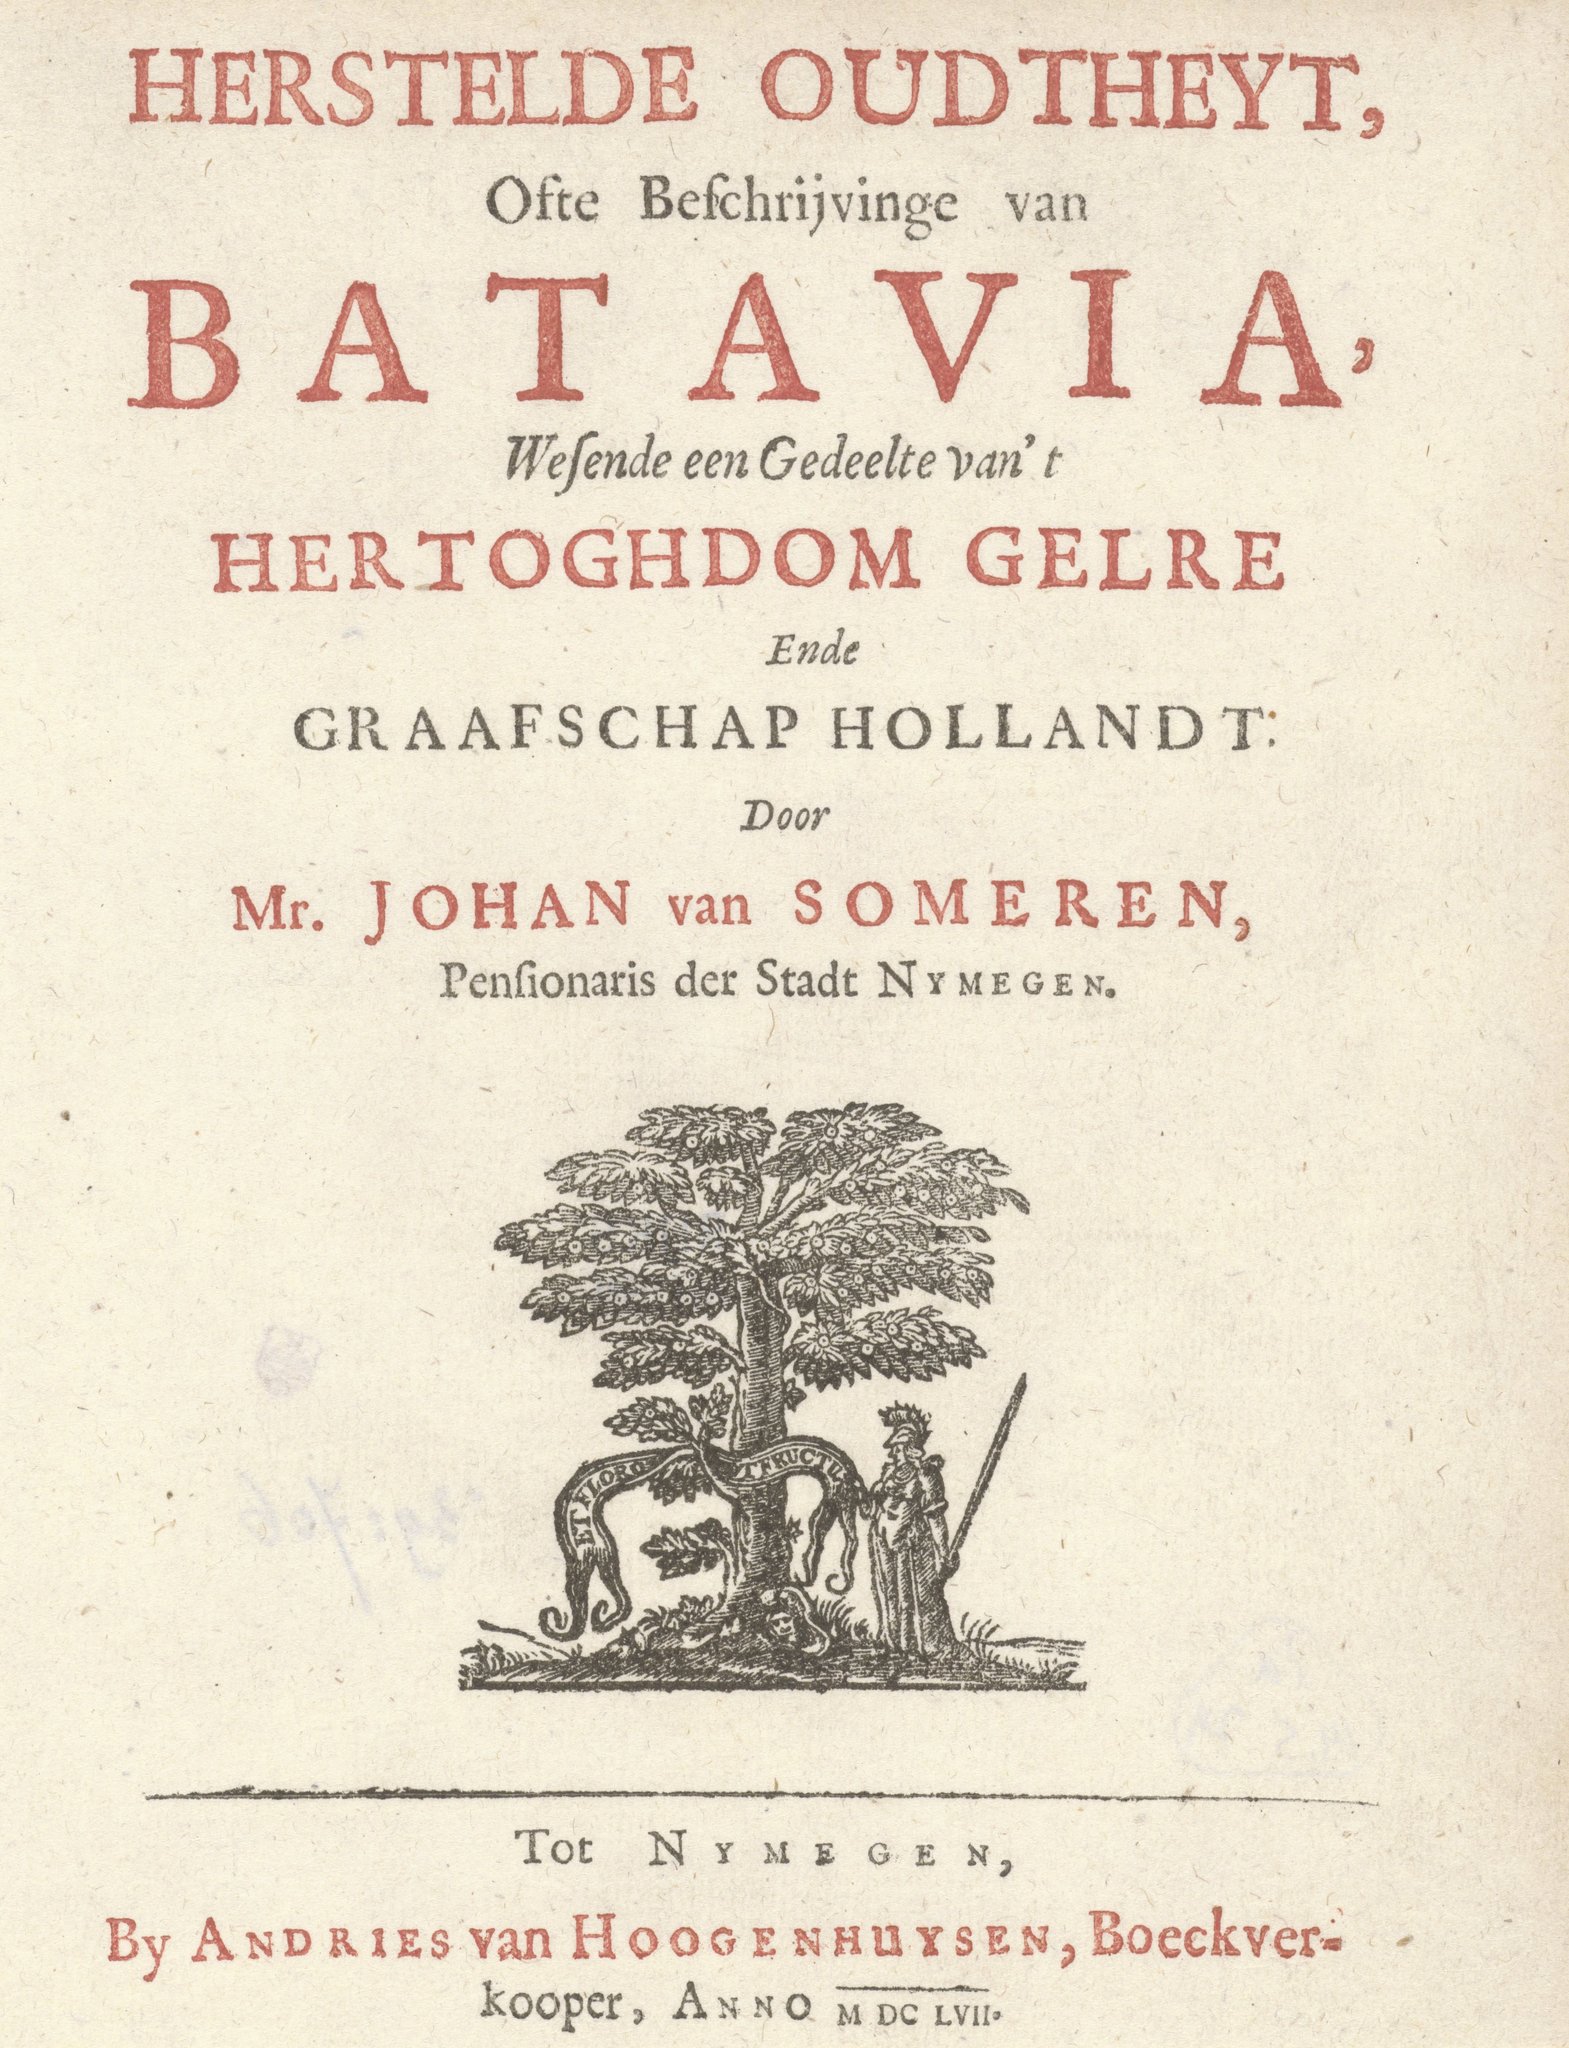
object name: text sheet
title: Titelpagina voor: J. van Someren, Herstelde oudtheyt, ofte Beschrĳvinge van Batavia, 1657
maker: andries van hoogenhuysen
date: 1657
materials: paper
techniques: letterpress printing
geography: nijmegen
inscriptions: collector's mark: Lugt 2760, collector's mark: Lugt 2166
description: Titelpagina voor: Someren, Johan van. Herstelde oudtheyt, ofte Beschrĳvinge van Batavia. Nijmegen: Andries van Hoogenhuysen, 1657.